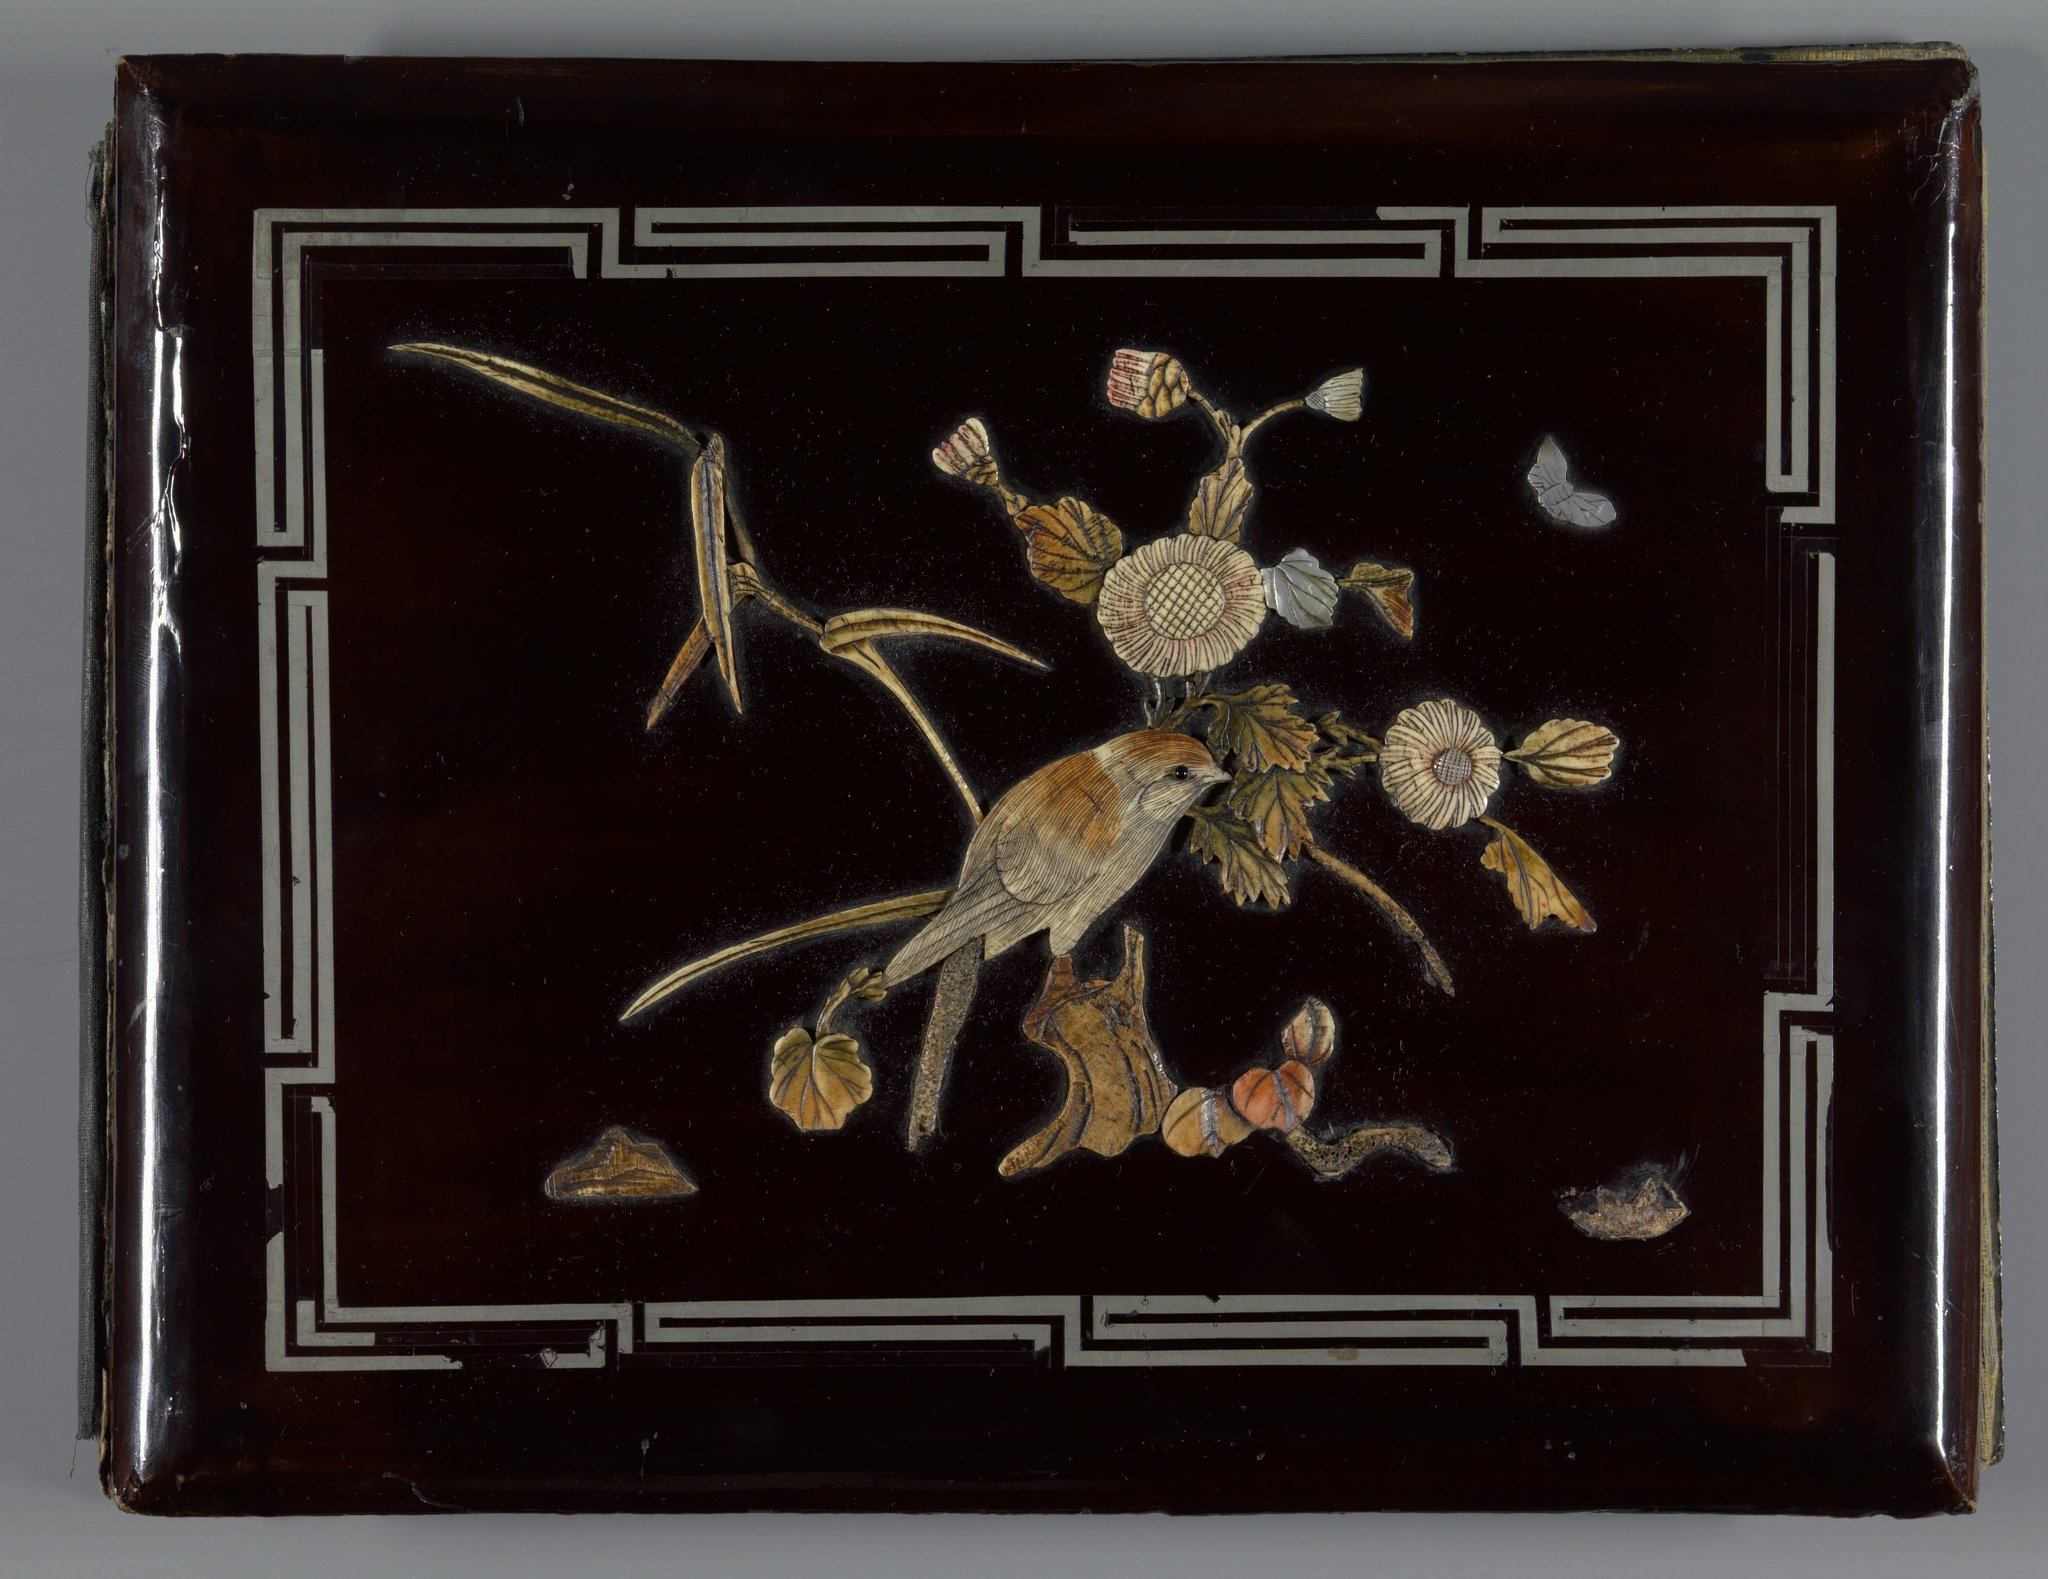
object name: slip in album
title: Fotoalbum (leeg)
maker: Anonymous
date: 1860-1900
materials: cardboard, paint, ivory, lacquer, leather, mother of pearl, paper, silk, textile, watercolor, wood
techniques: bookbinding, brush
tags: flowers, birds, book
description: Fotoalbum met twee lakpanelen. Op het voorpaneel een vogel op een tak met bloemen, van ivoor en parelmoer; het achterpaneel is effen zwart. Het album bevat vijf kartonnen bladen overtrokken met zijde. Elke pagina heeft uitsparingen voor twee kabinetfoto's. Daaromheen zijn geschilderde versieringen aangebracht: bloemen, vogels en landschappen.